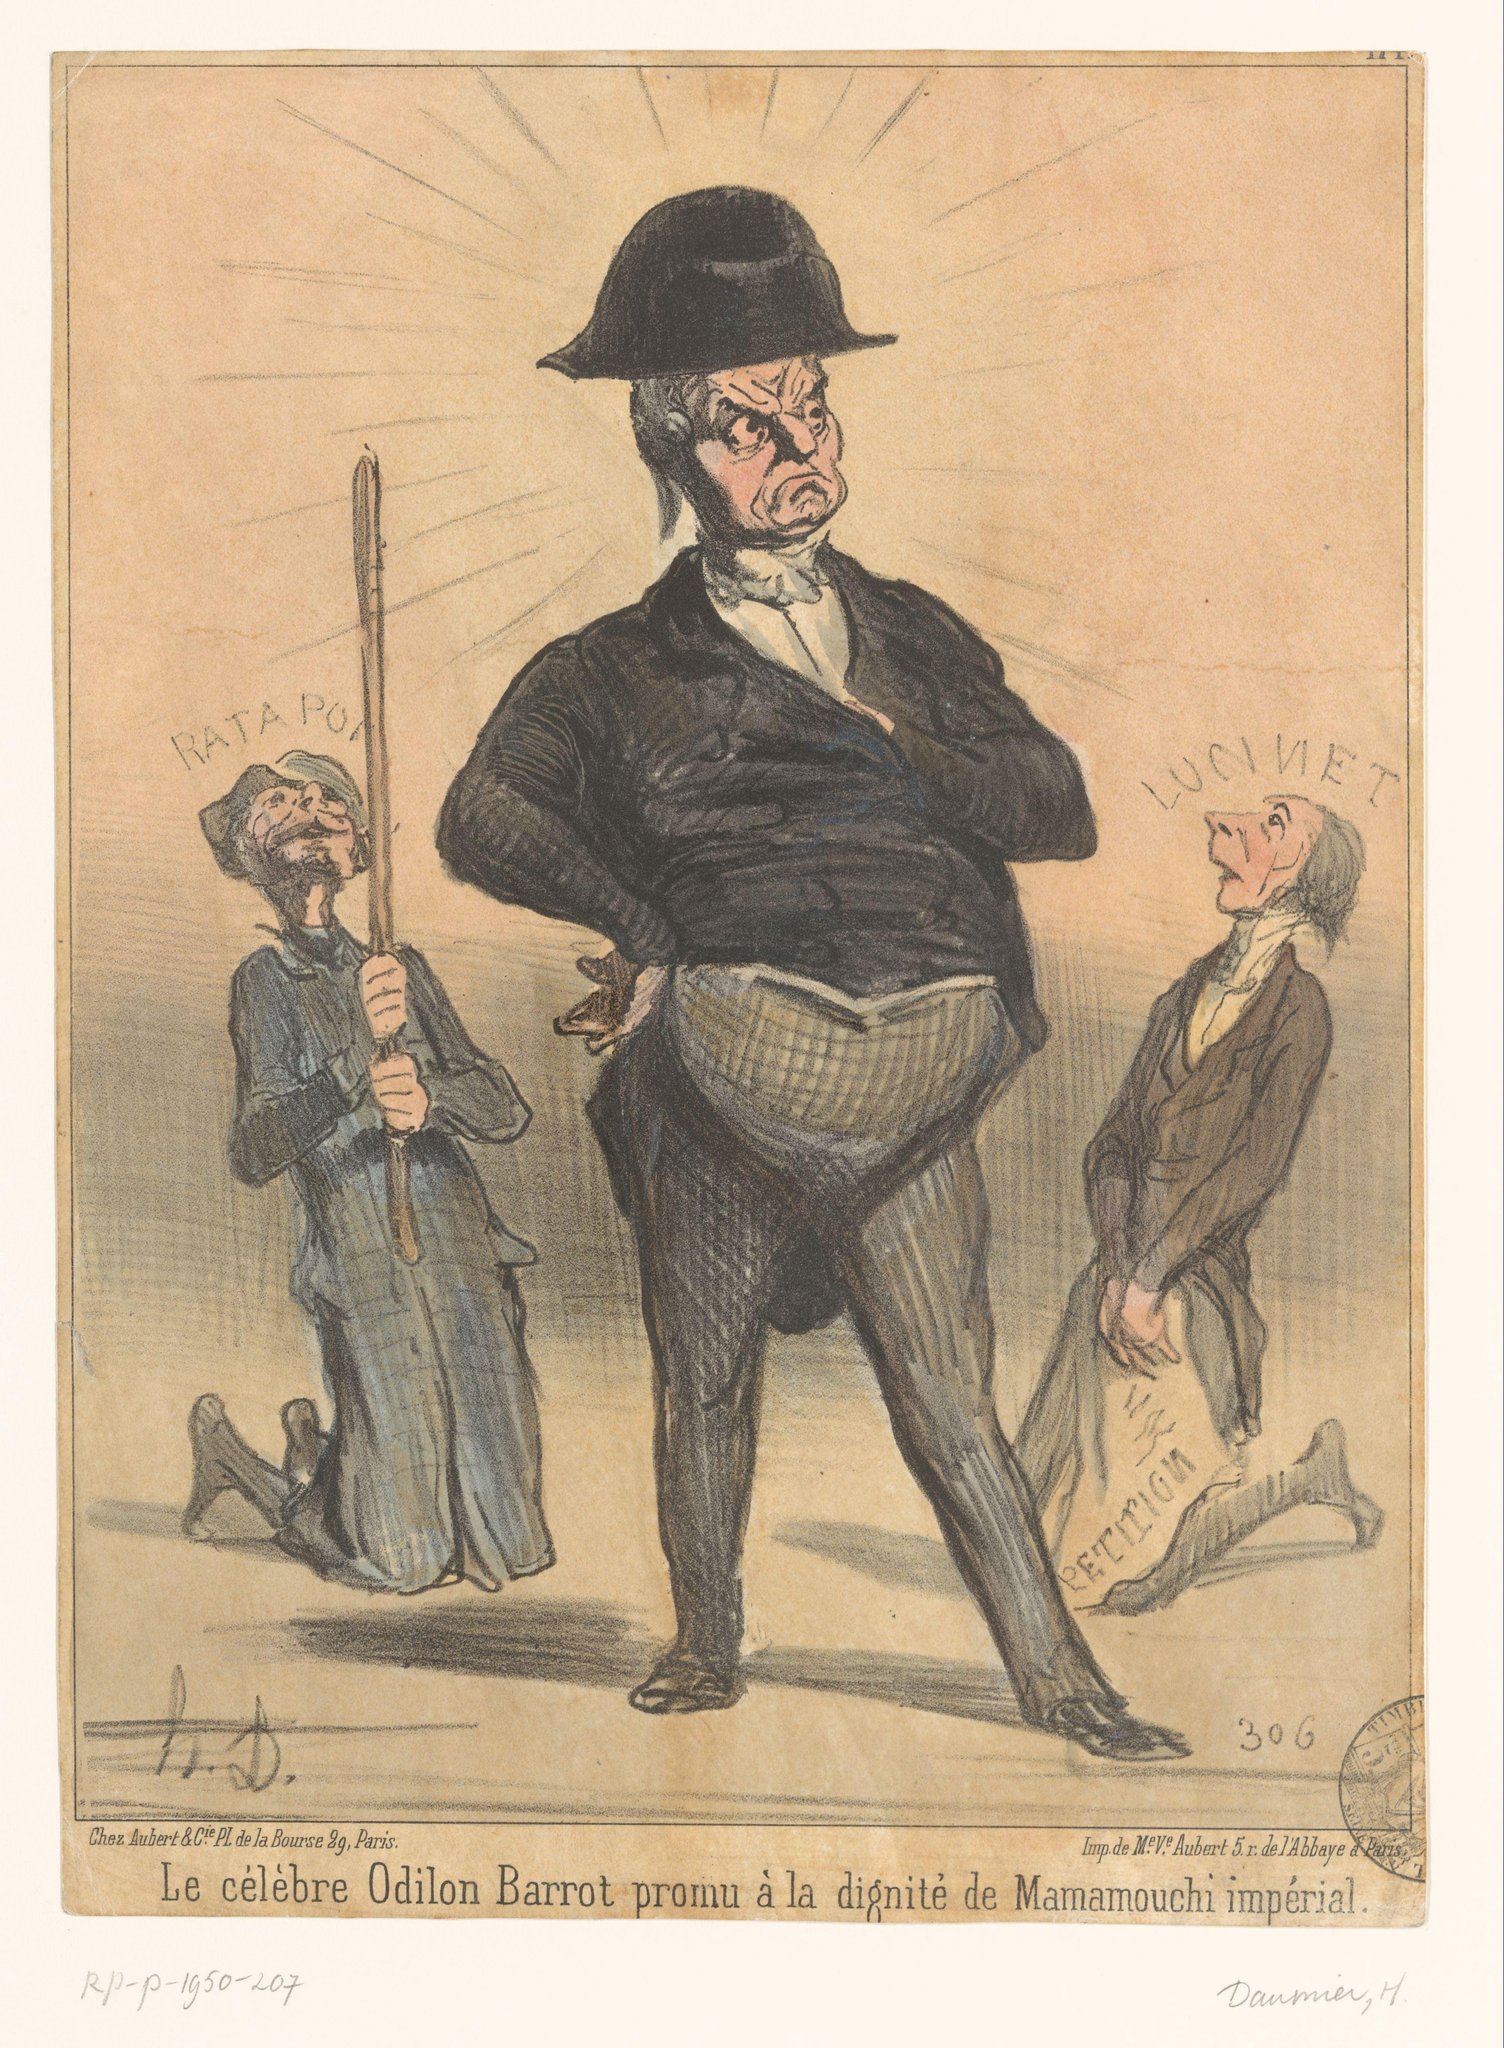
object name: cartoon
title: Actualités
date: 1851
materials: paper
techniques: hand coloring, lithograph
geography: paris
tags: politician, caricatures (human types), historical persons, political caricatures and satires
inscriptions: collector's mark: Lugt 2228a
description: Prent gebruikt voor: Le Charivari, 28 juli 1851.